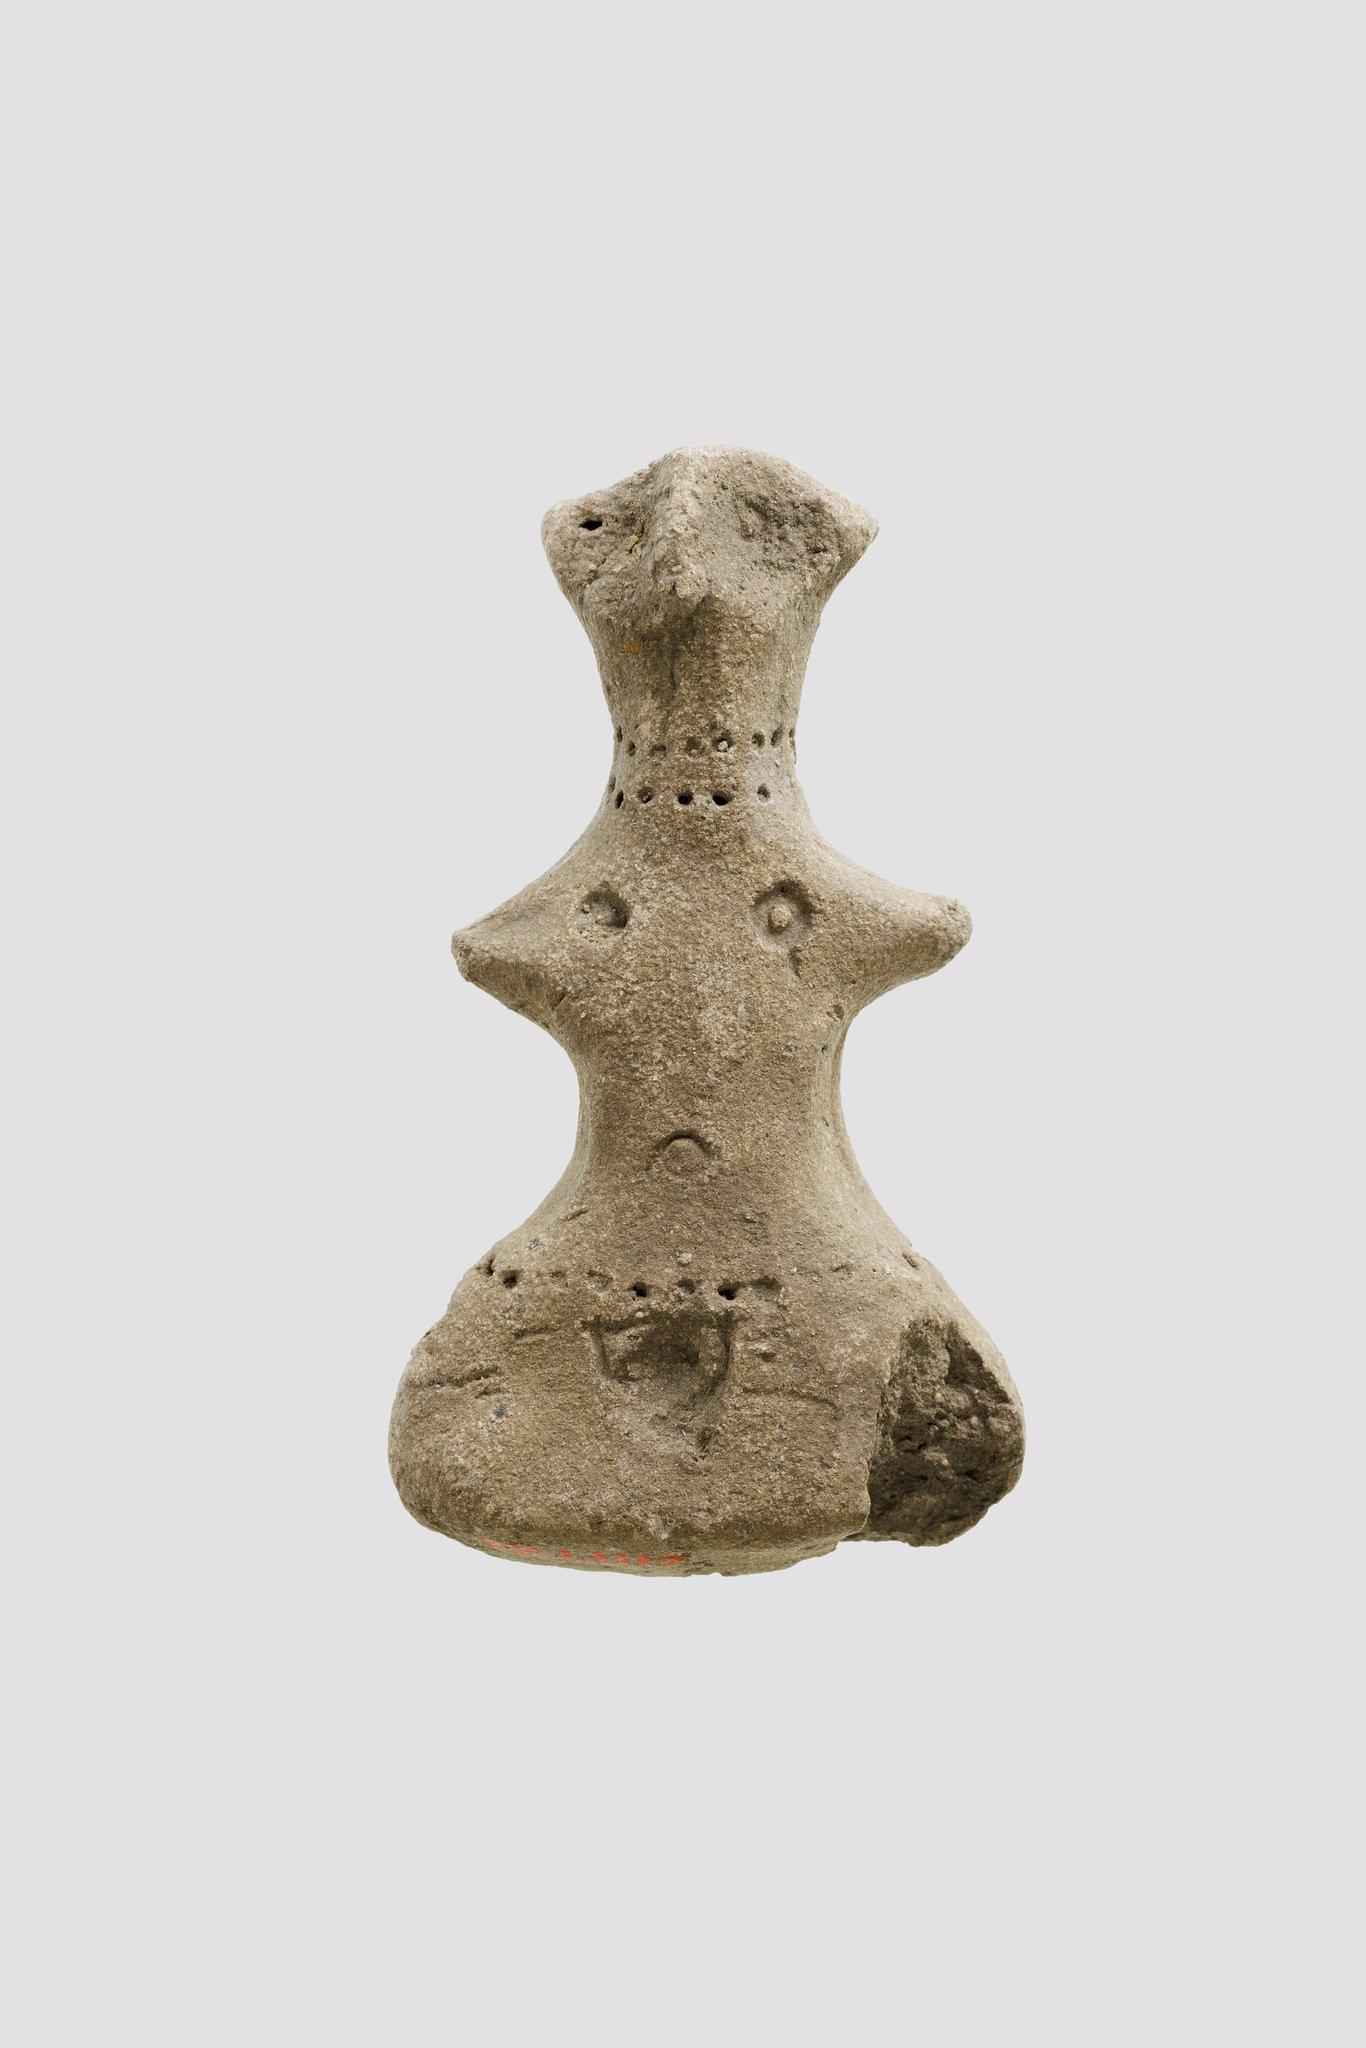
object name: figurine, woman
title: Figurine of female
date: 1981-1640 BCE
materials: clay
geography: egypt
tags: women